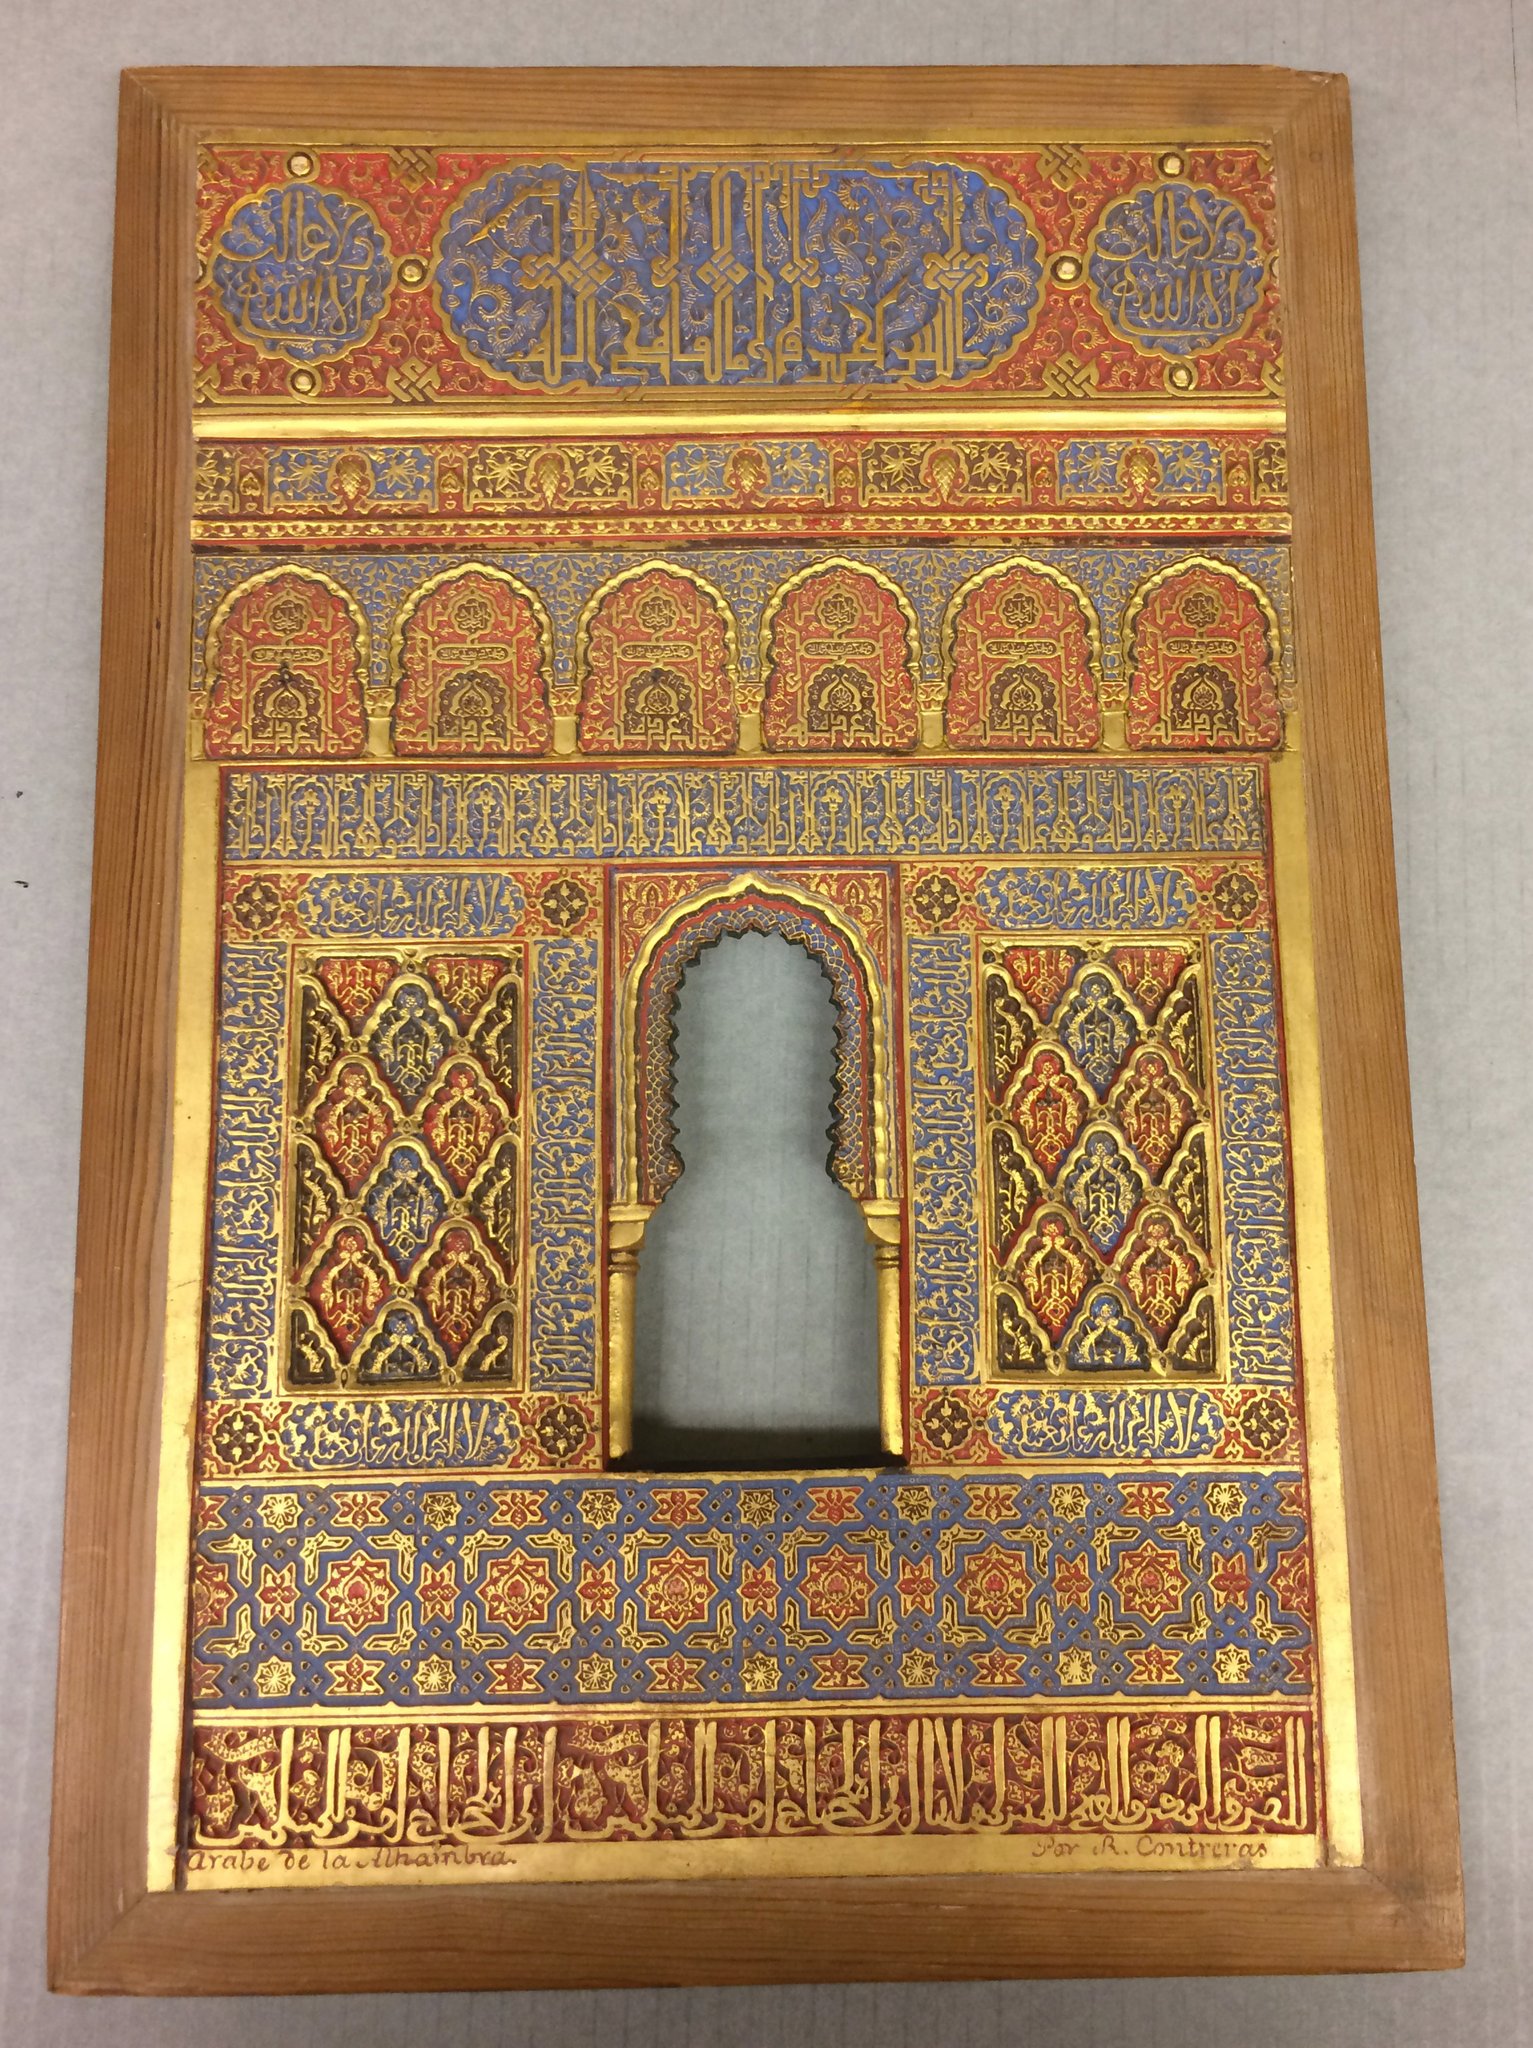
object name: architectural model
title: Architectural Model Based on the Alhambra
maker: rafael contreras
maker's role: artist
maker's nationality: spanish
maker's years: 1826-1890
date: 1801-1900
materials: plaster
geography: spain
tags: architecture